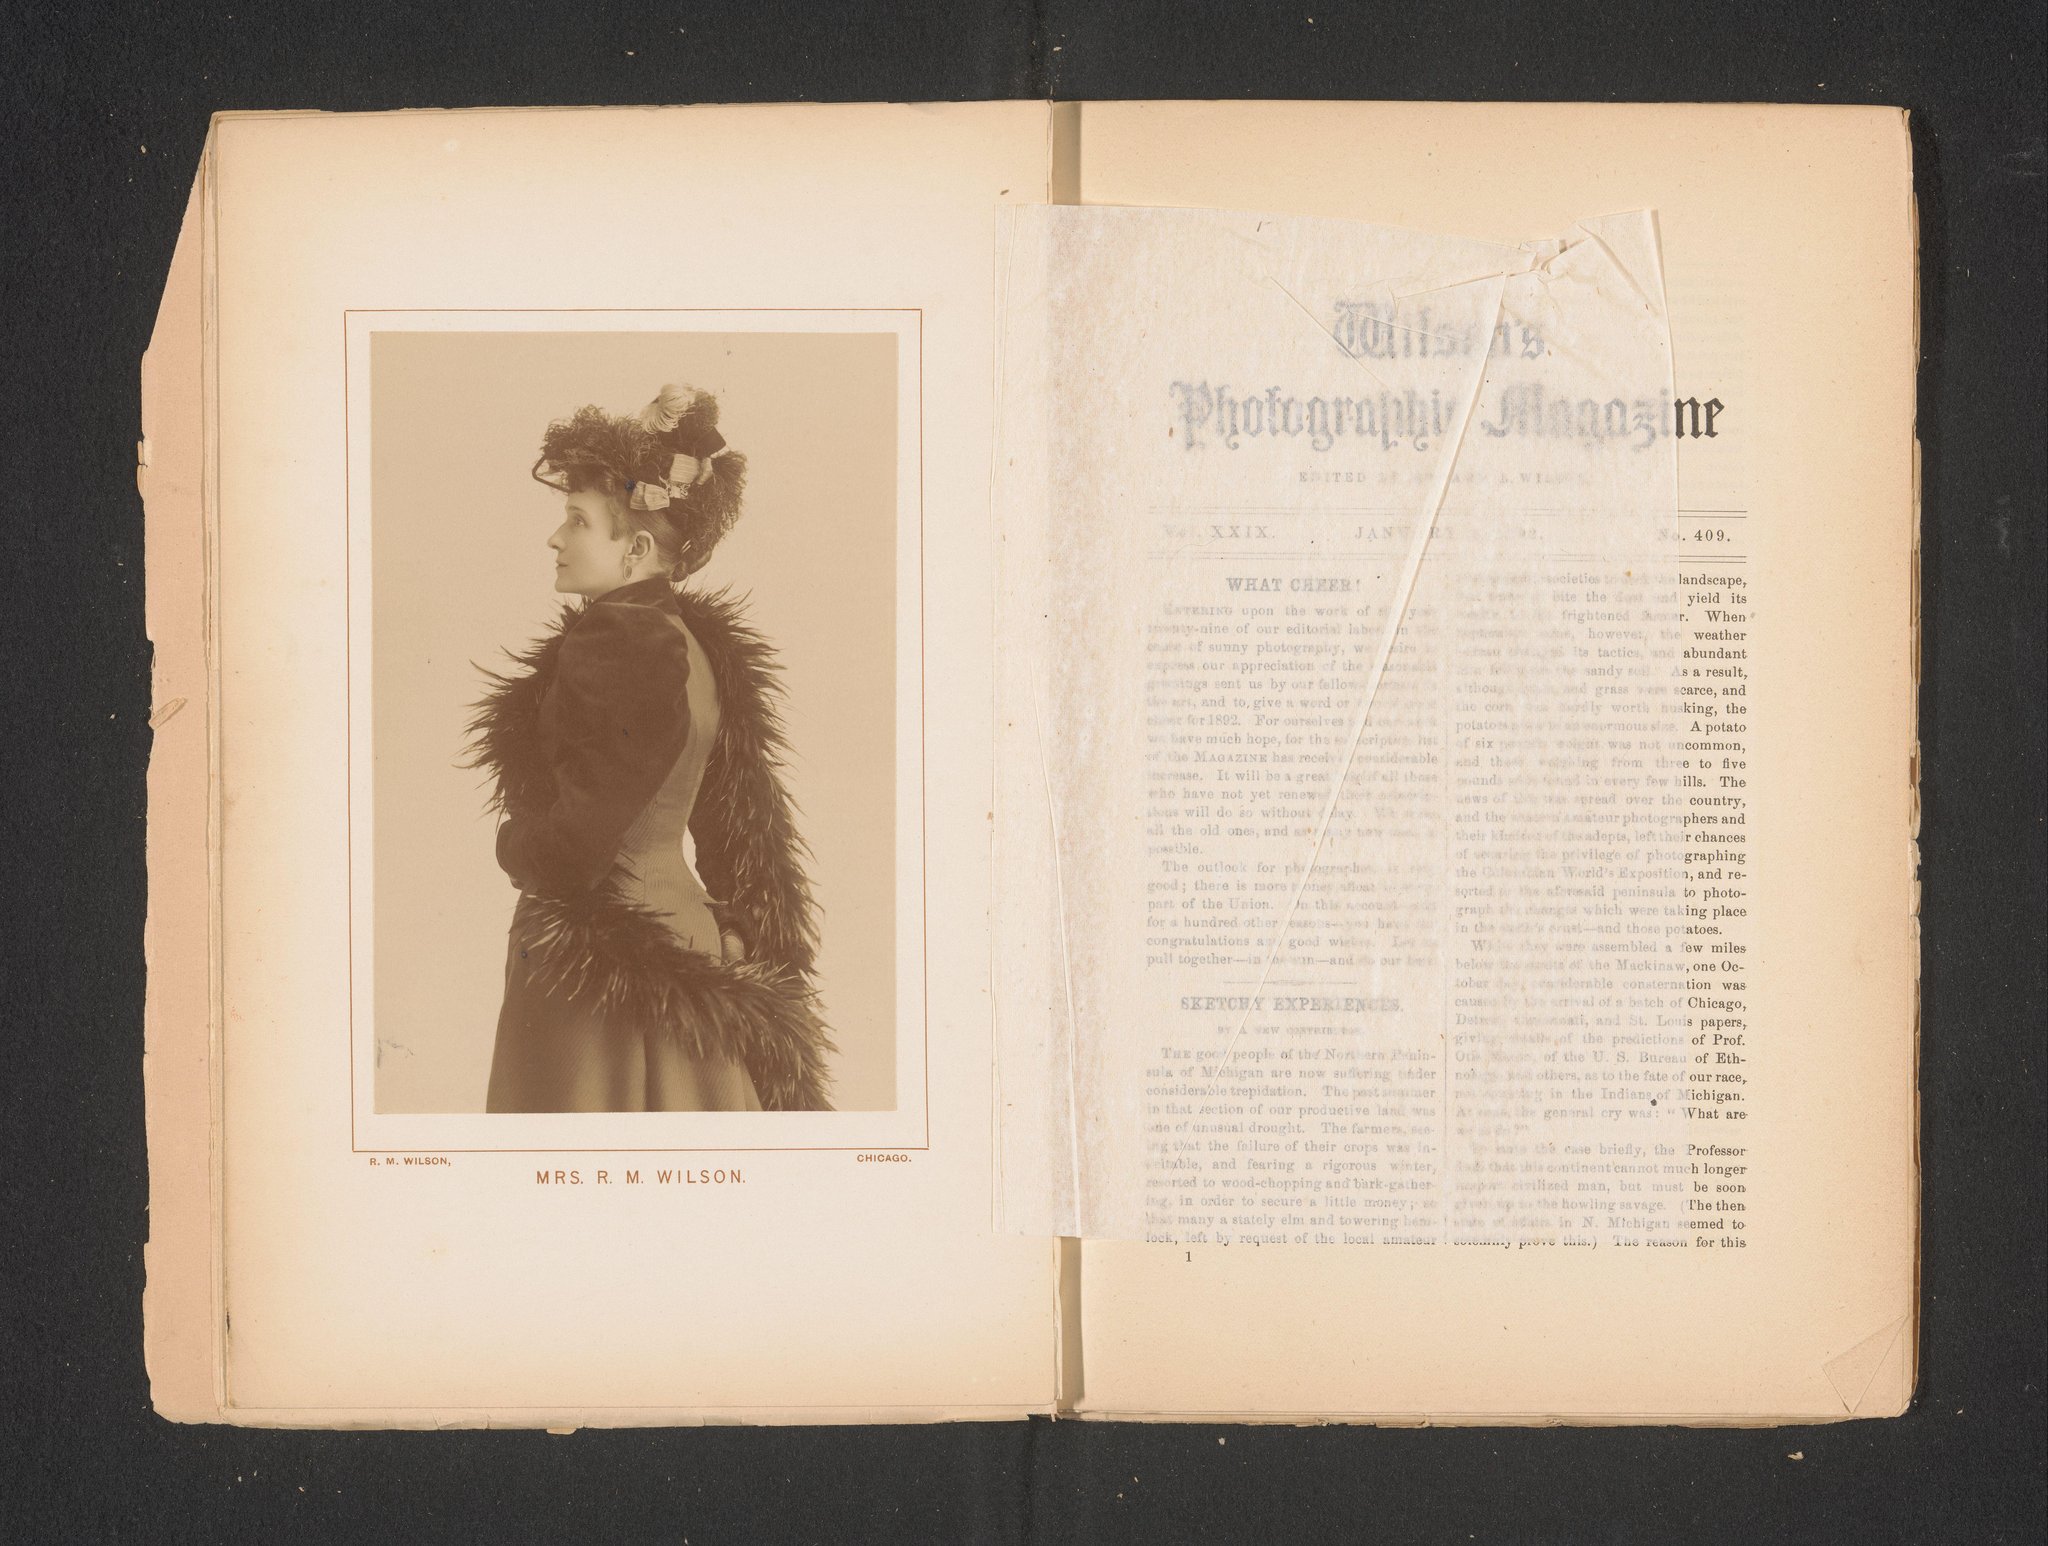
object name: photograph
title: Portret van mevrouw R. M. Wilson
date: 1887-1892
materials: photographic support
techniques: albumen print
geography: philadelphia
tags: r.m. wilson (mevrouw), historical persons - bb - woman